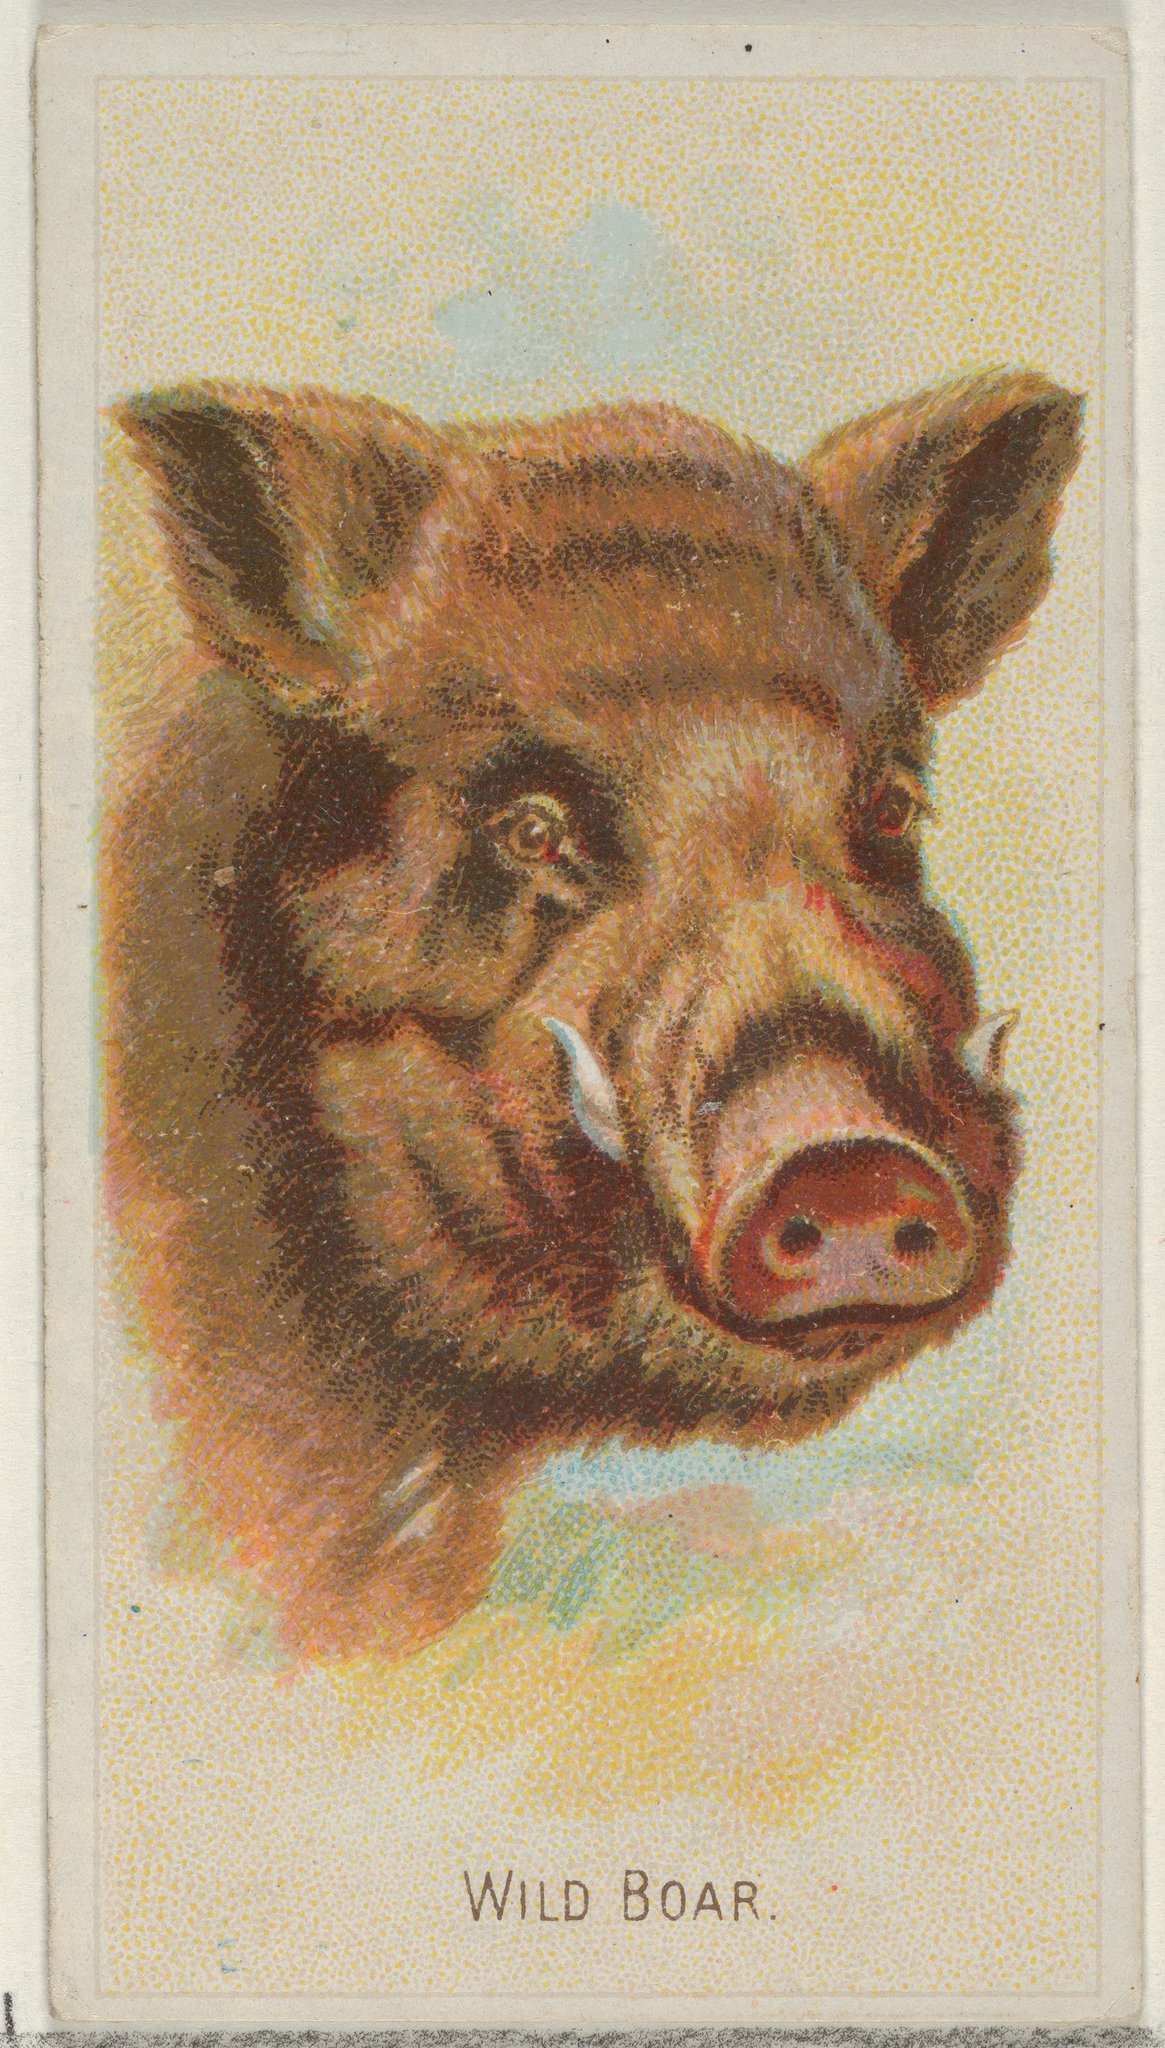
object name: print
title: Wild Boar, from the Wild Animals of the World series (N25) for Allen & Ginter Cigarettes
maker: allen & ginter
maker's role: publisher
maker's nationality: american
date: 1888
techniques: color lithograph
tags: boars